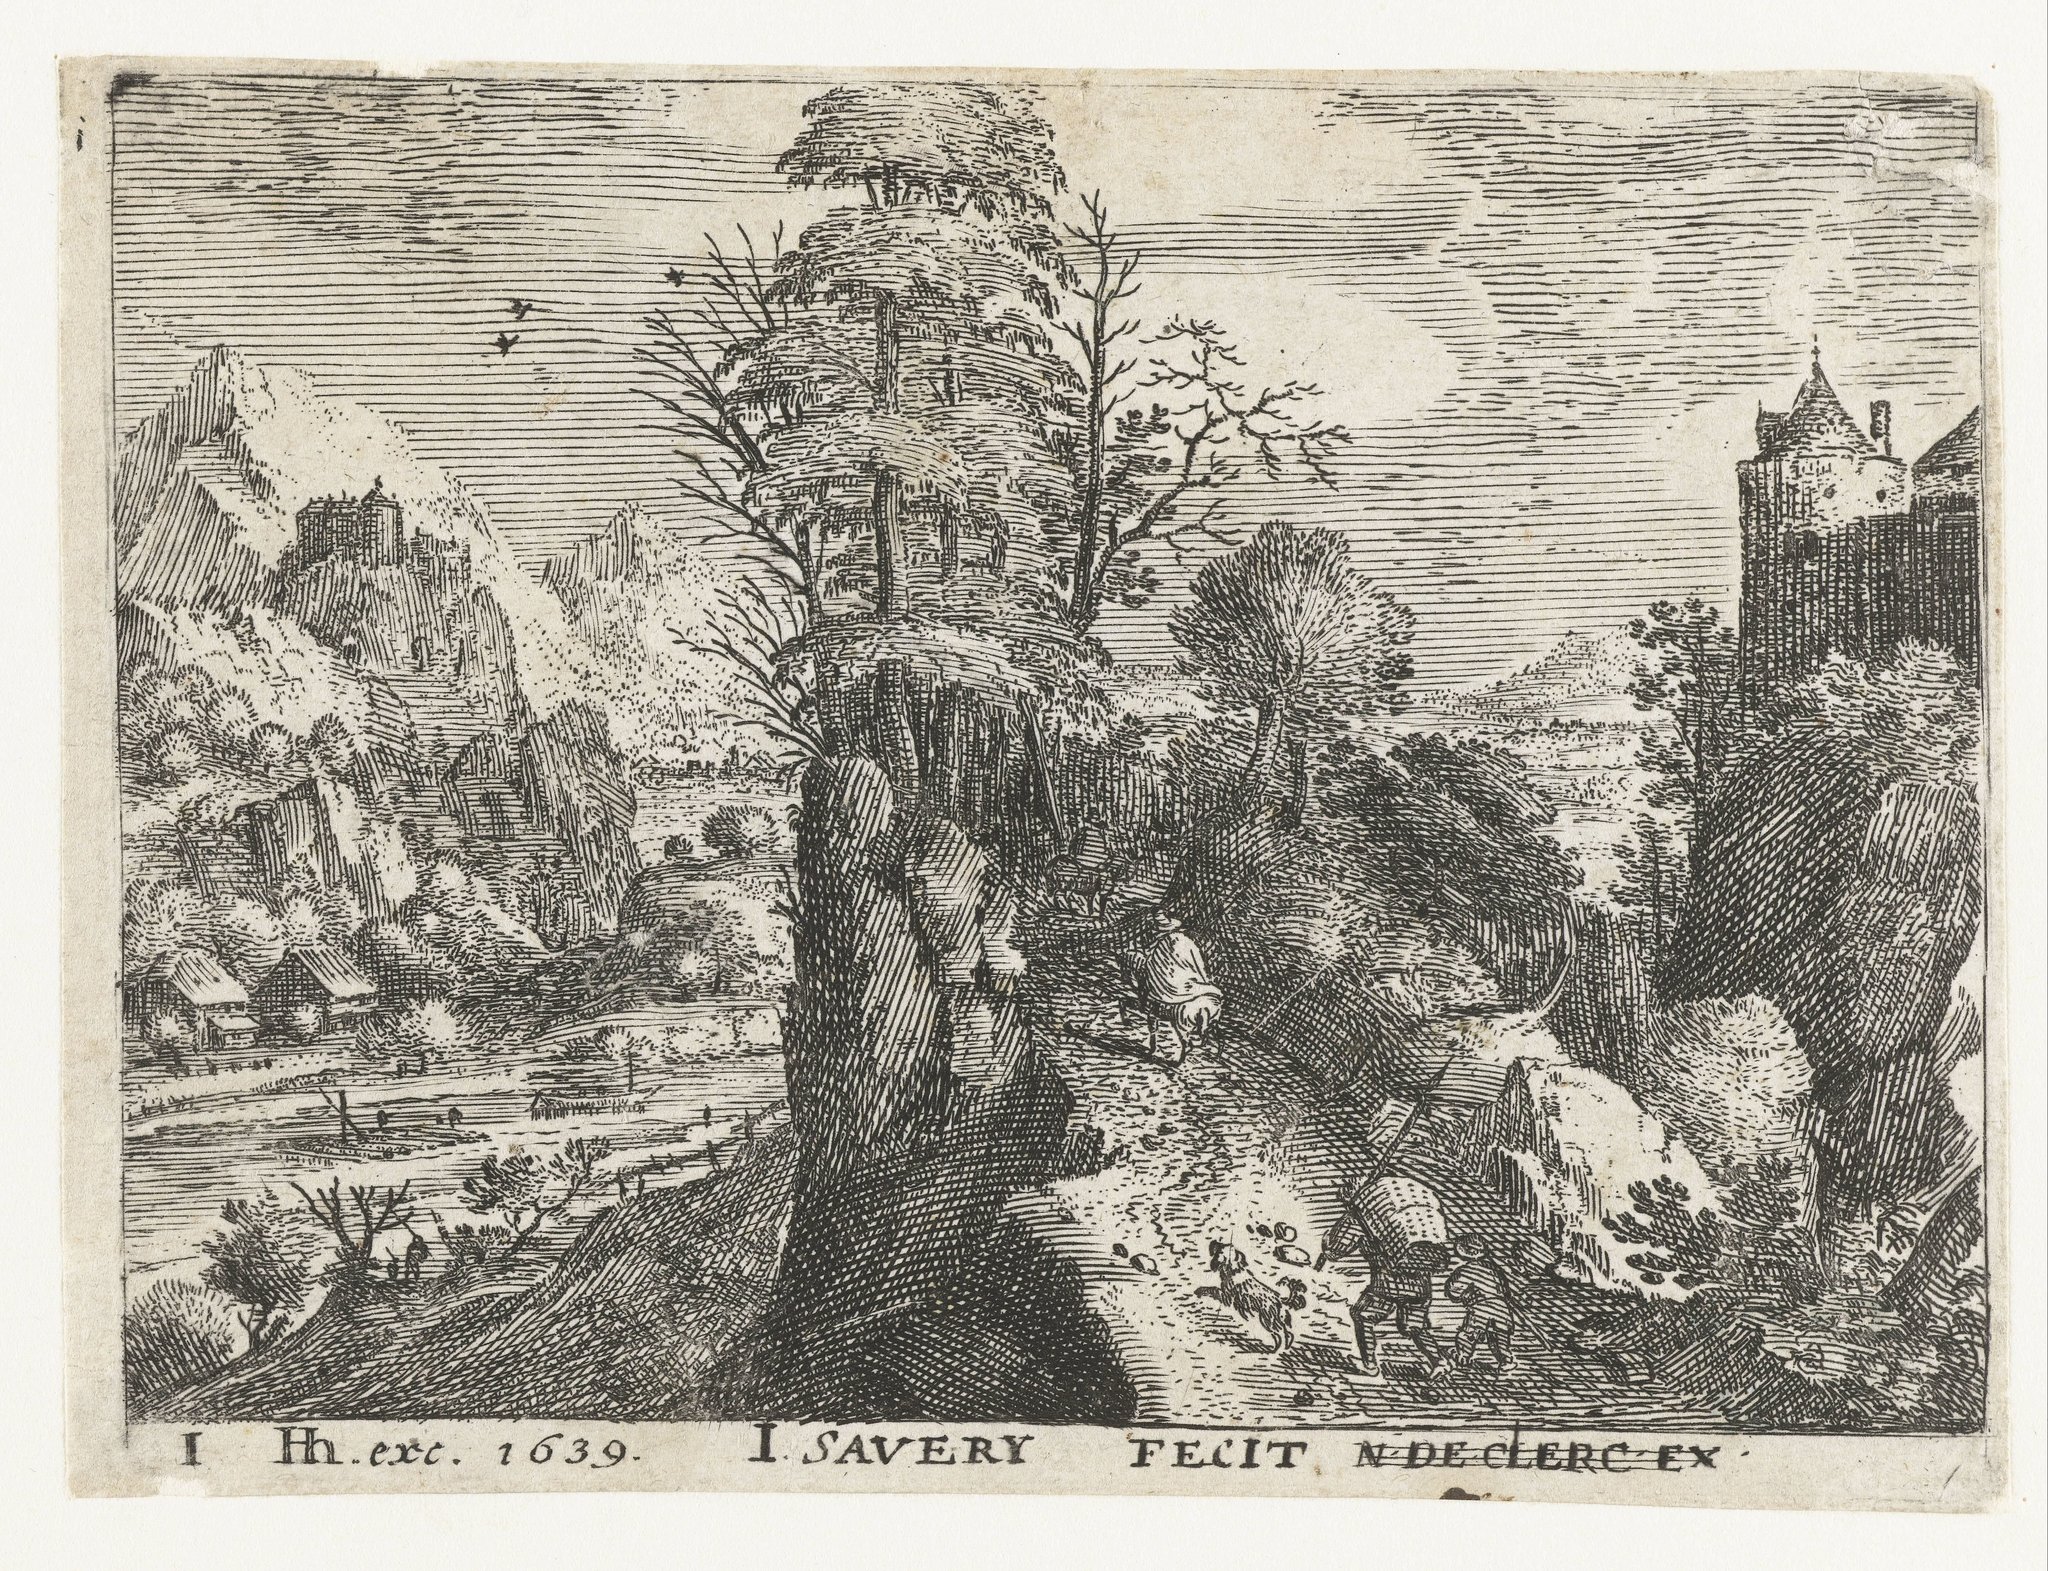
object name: print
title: Landschap met reizigers op steile rots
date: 1584-1603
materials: paper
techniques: engraving, etching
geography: the hague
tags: landscapes in the temperate zone, 'en route', traveller under way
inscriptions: collector's mark: ‘RYKSMUSM’ Lugt 2228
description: In een bergachtig landschap lopen twee reizigers (een man met een mand op zijn rug en een jongen) met een hond een steil pad op, achter twee ruiters aan. Links een rivier, rechts de toren van een kasteel. Deze prent is onderdeel van een serie van zes landschappen met reizigers.